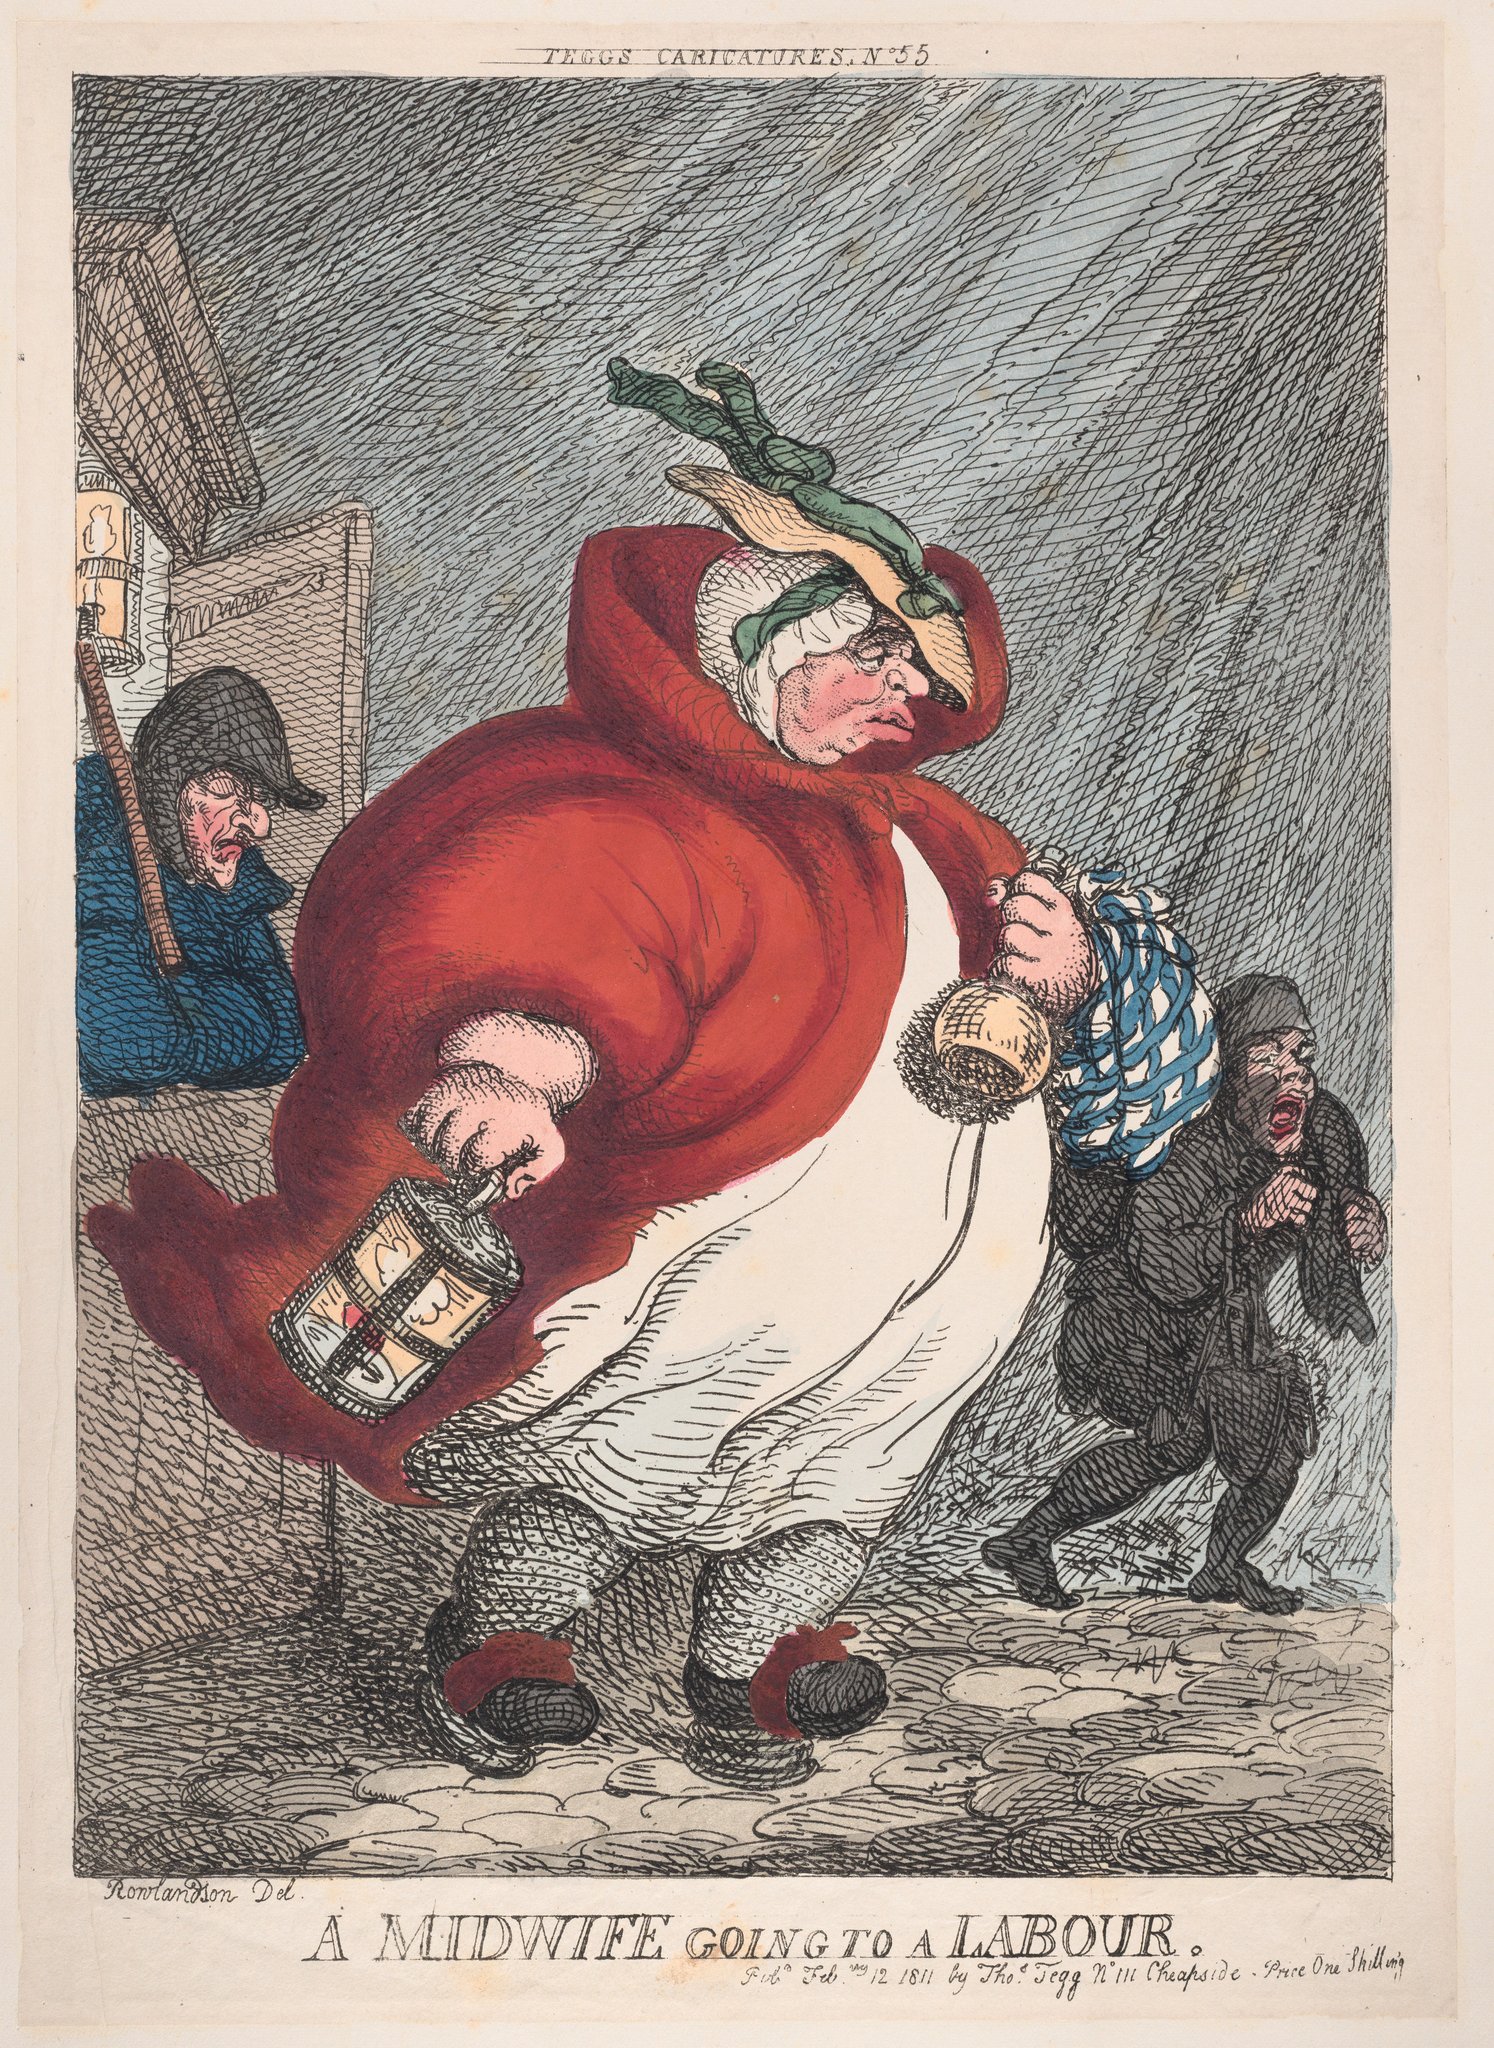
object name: print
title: A Midwife Going to a Labour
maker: thomas rowlandson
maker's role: artist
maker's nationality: british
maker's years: 1757-1827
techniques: etching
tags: men,women,rain,caricature